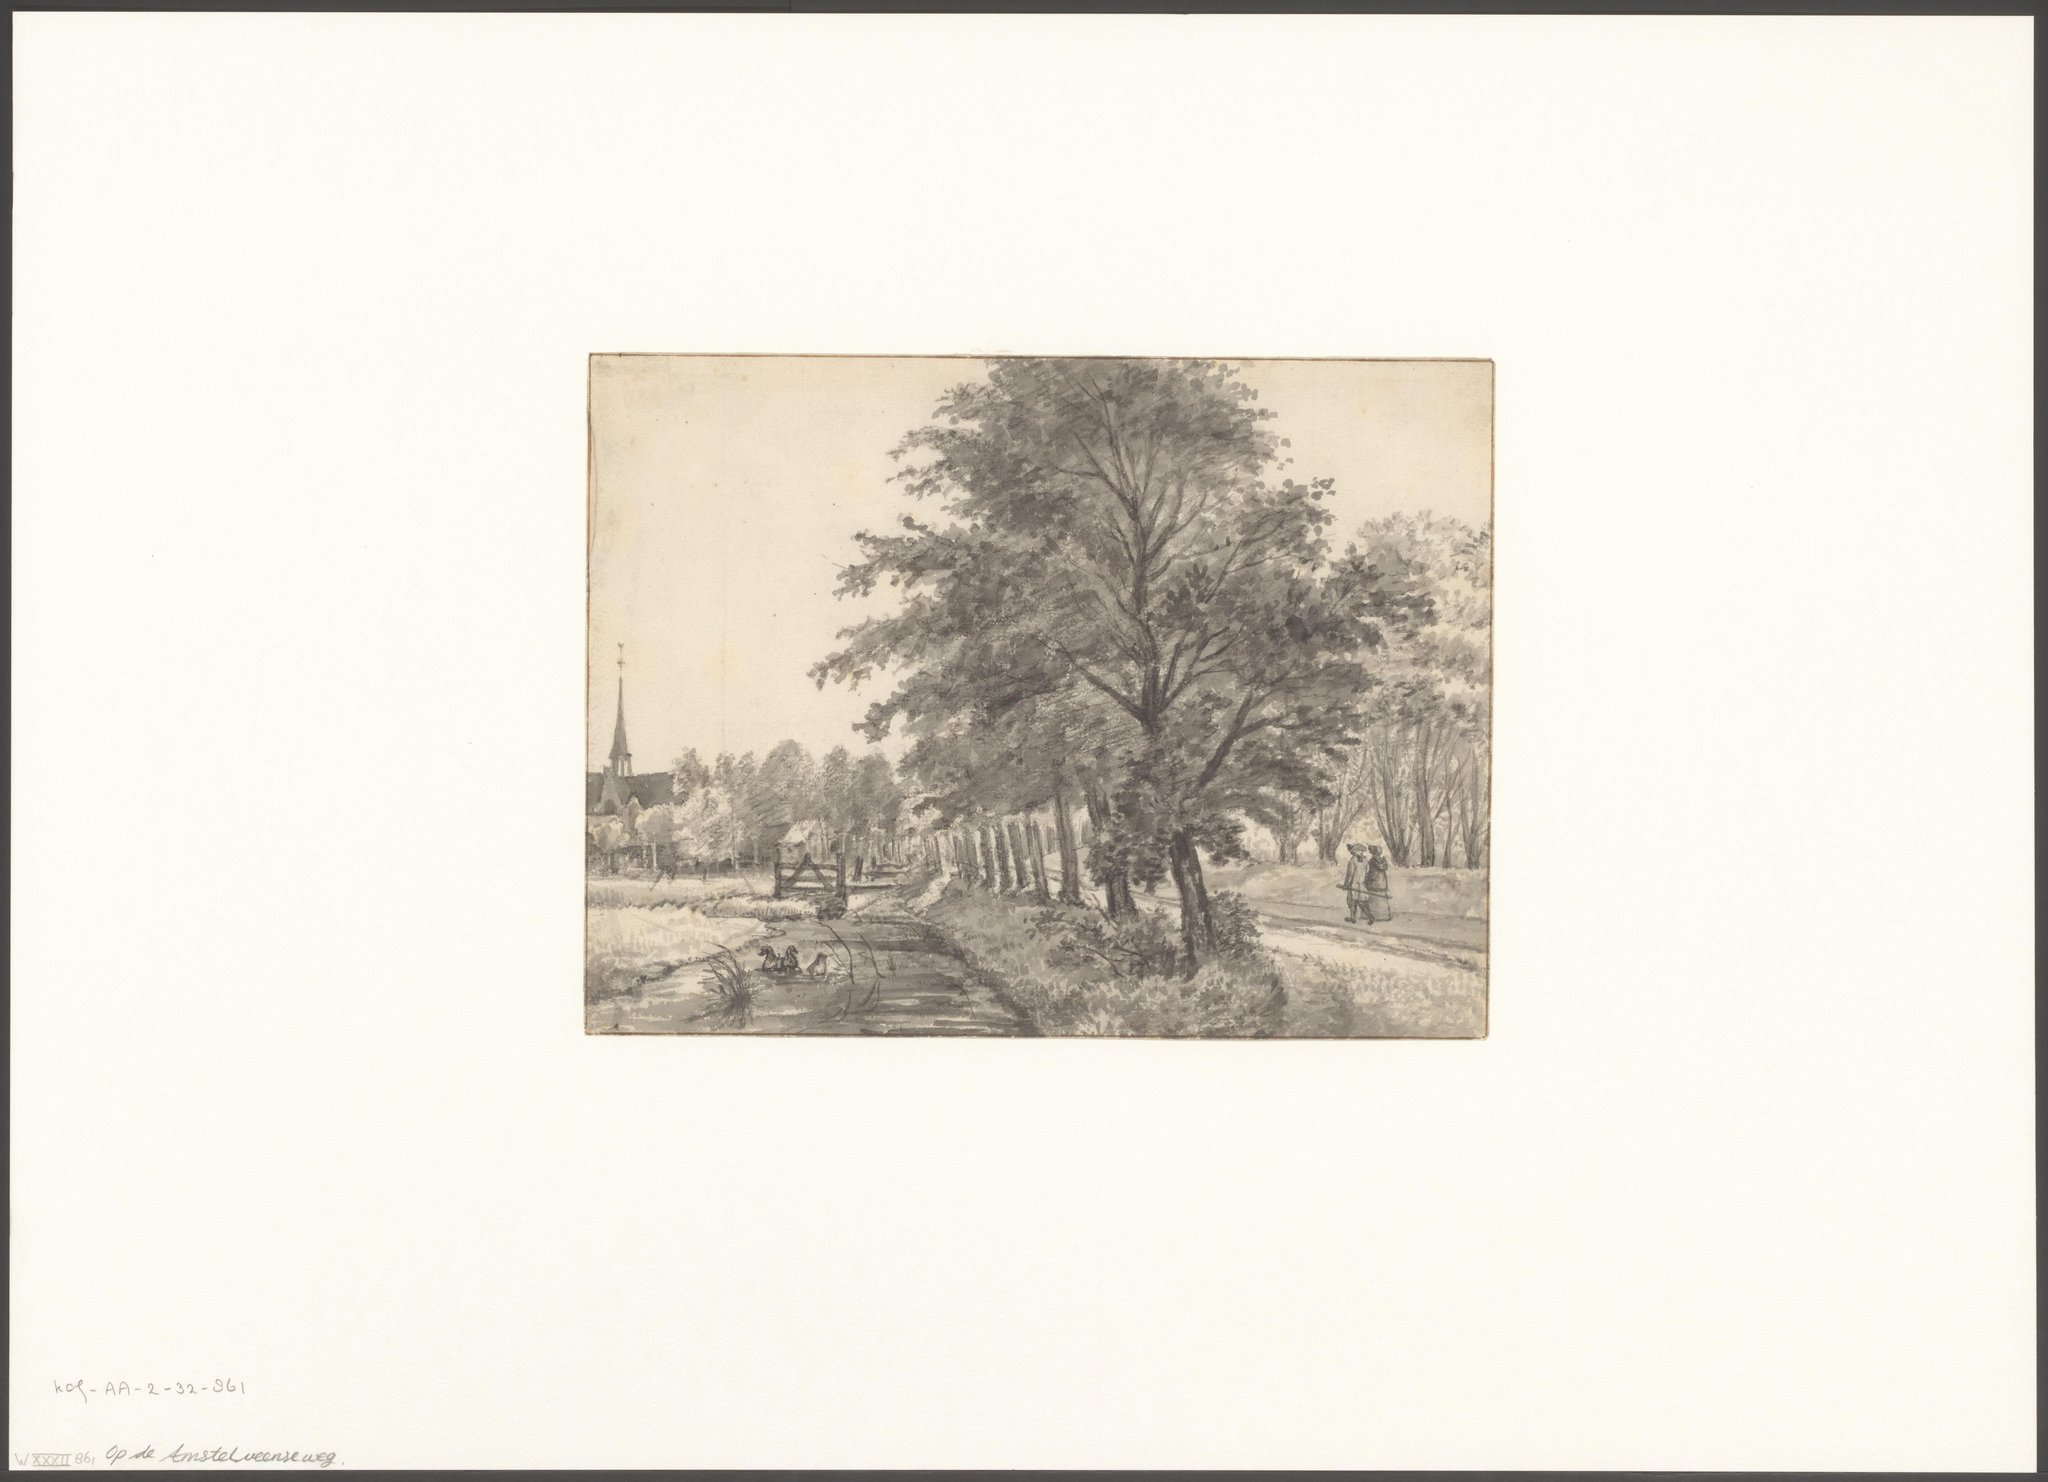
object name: drawing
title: Gezicht op de Amstelveenseweg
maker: gerrit lamberts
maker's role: bookseller, draughtsman, print maker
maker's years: 1776-1850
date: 1816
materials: chalk, ink, paper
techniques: brush, pen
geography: amsterdam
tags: village, road, path, small canal, ditch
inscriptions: signature and date: ‘G. Lamberts. 1816’, inscription: ‘Afbeelding van de Amstel- / veenscheweg voor de bestrating’, collector's mark: Lugt 800a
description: Tekening binnen de Atlas Van Eck ingedeeld op wijknummer 32.